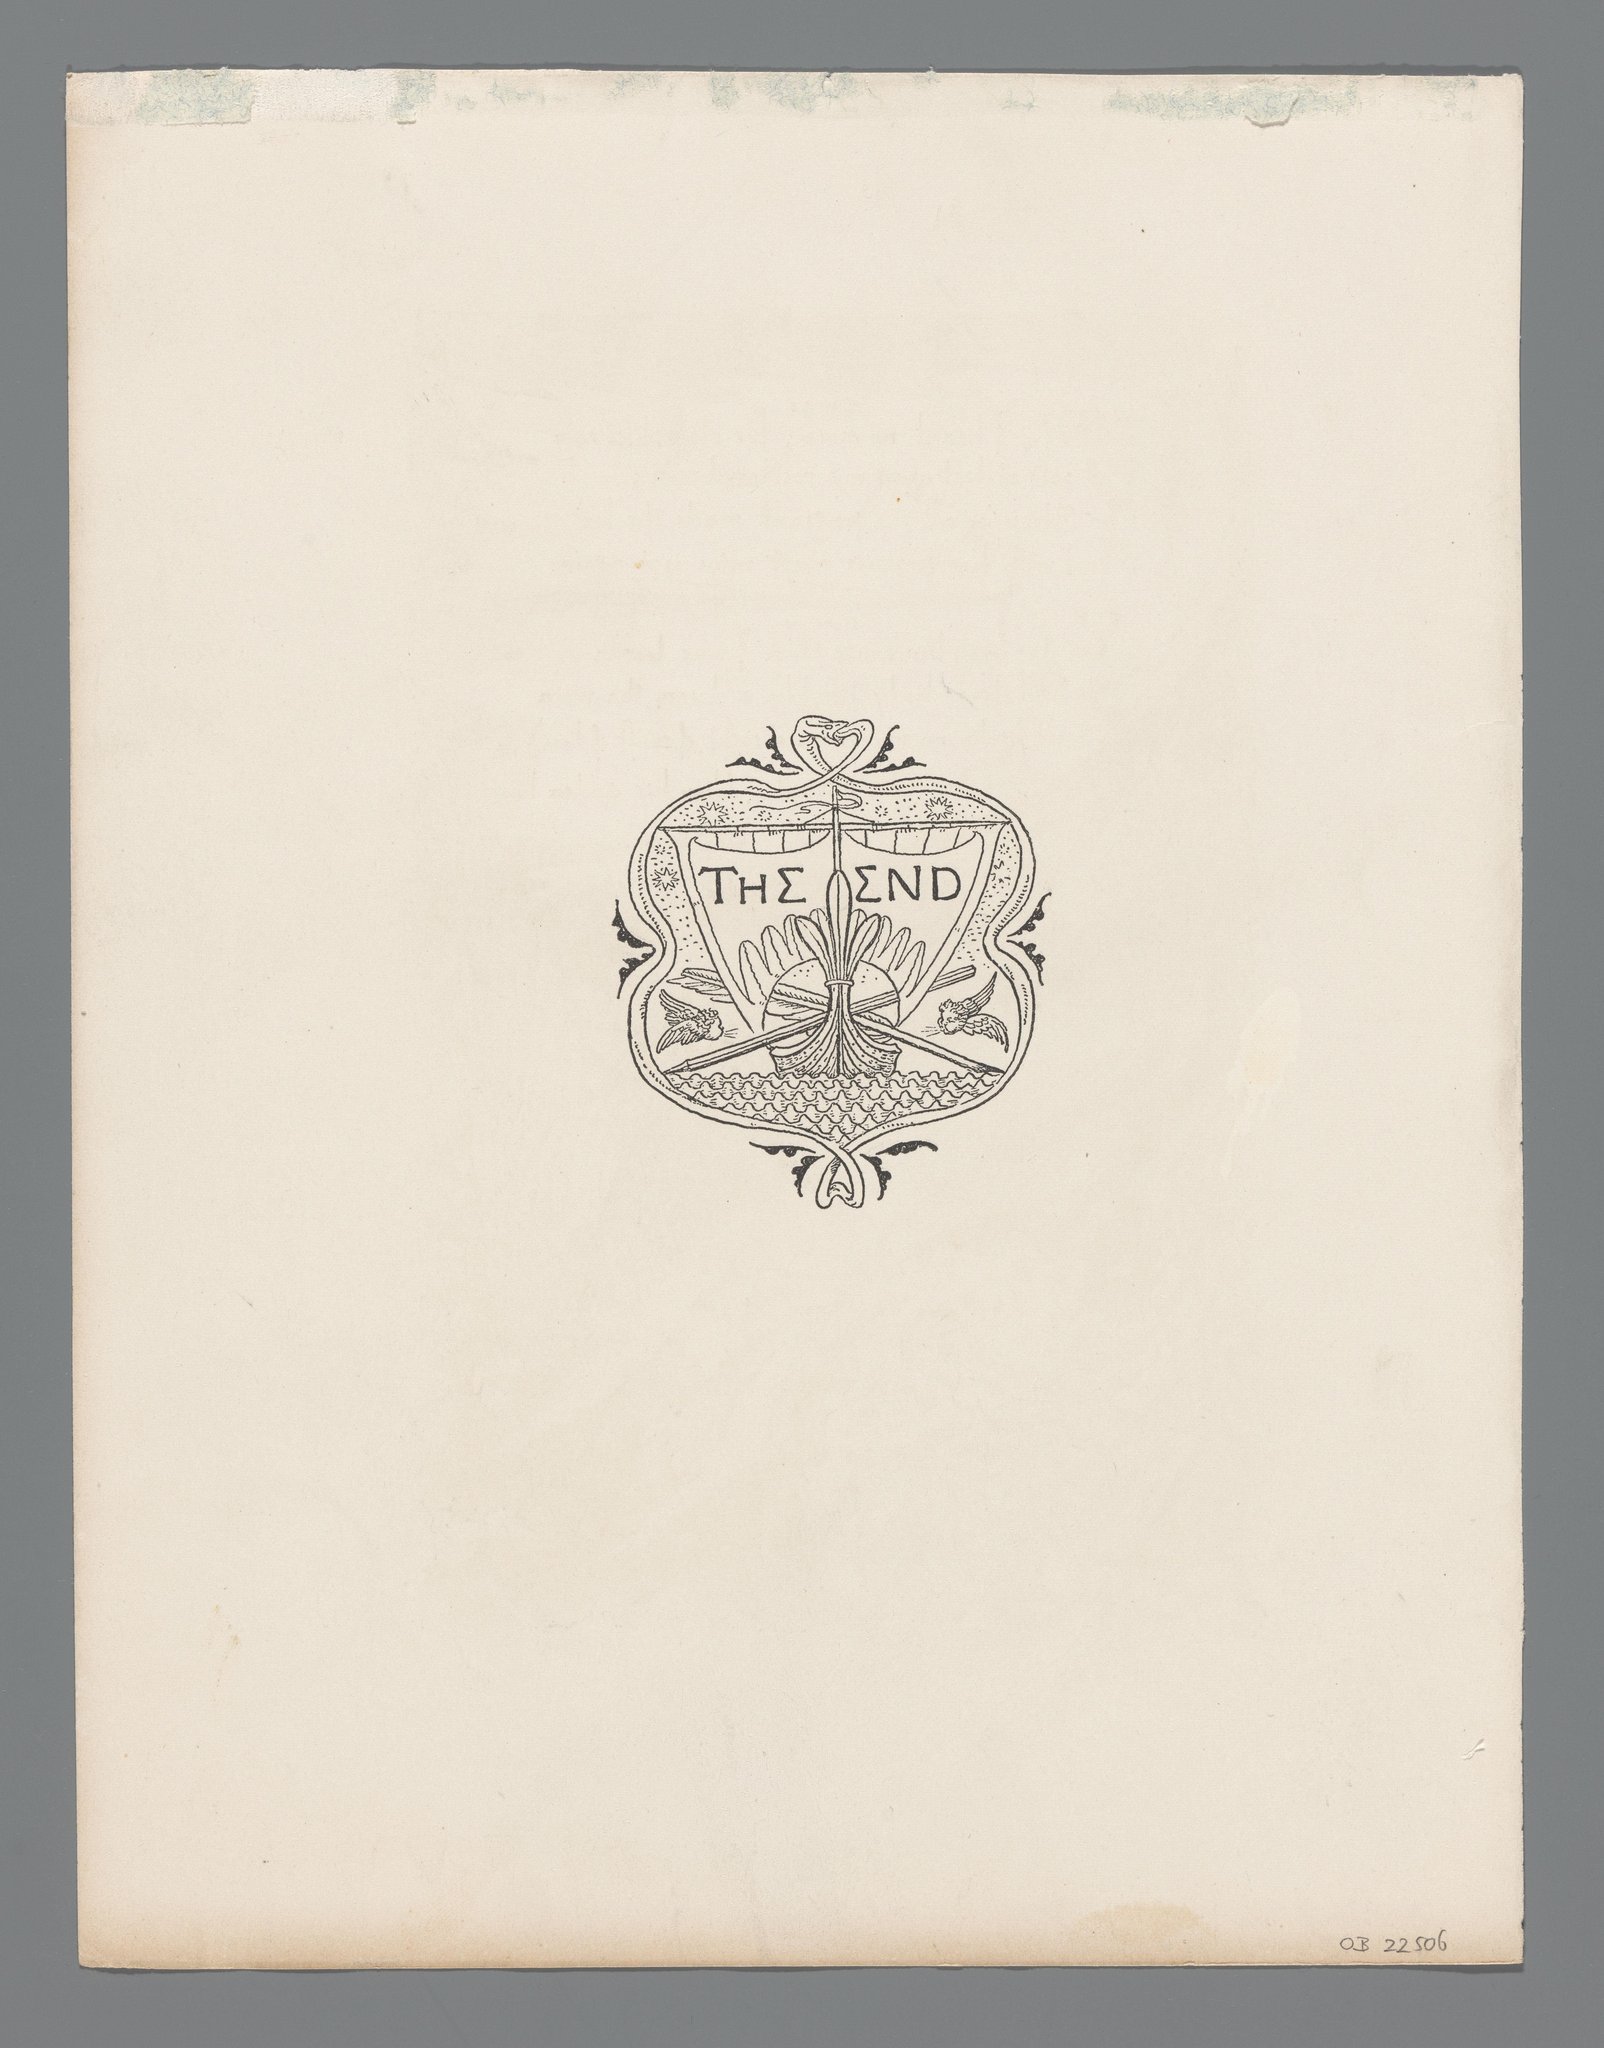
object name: print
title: The end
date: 1886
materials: paper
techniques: engraving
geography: london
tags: sailing-ship, sailing-boat, ornament ~ cartouche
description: Prent uit: Crane, Walter. The sirens three. Londen: Macmillan & Co., 1886.